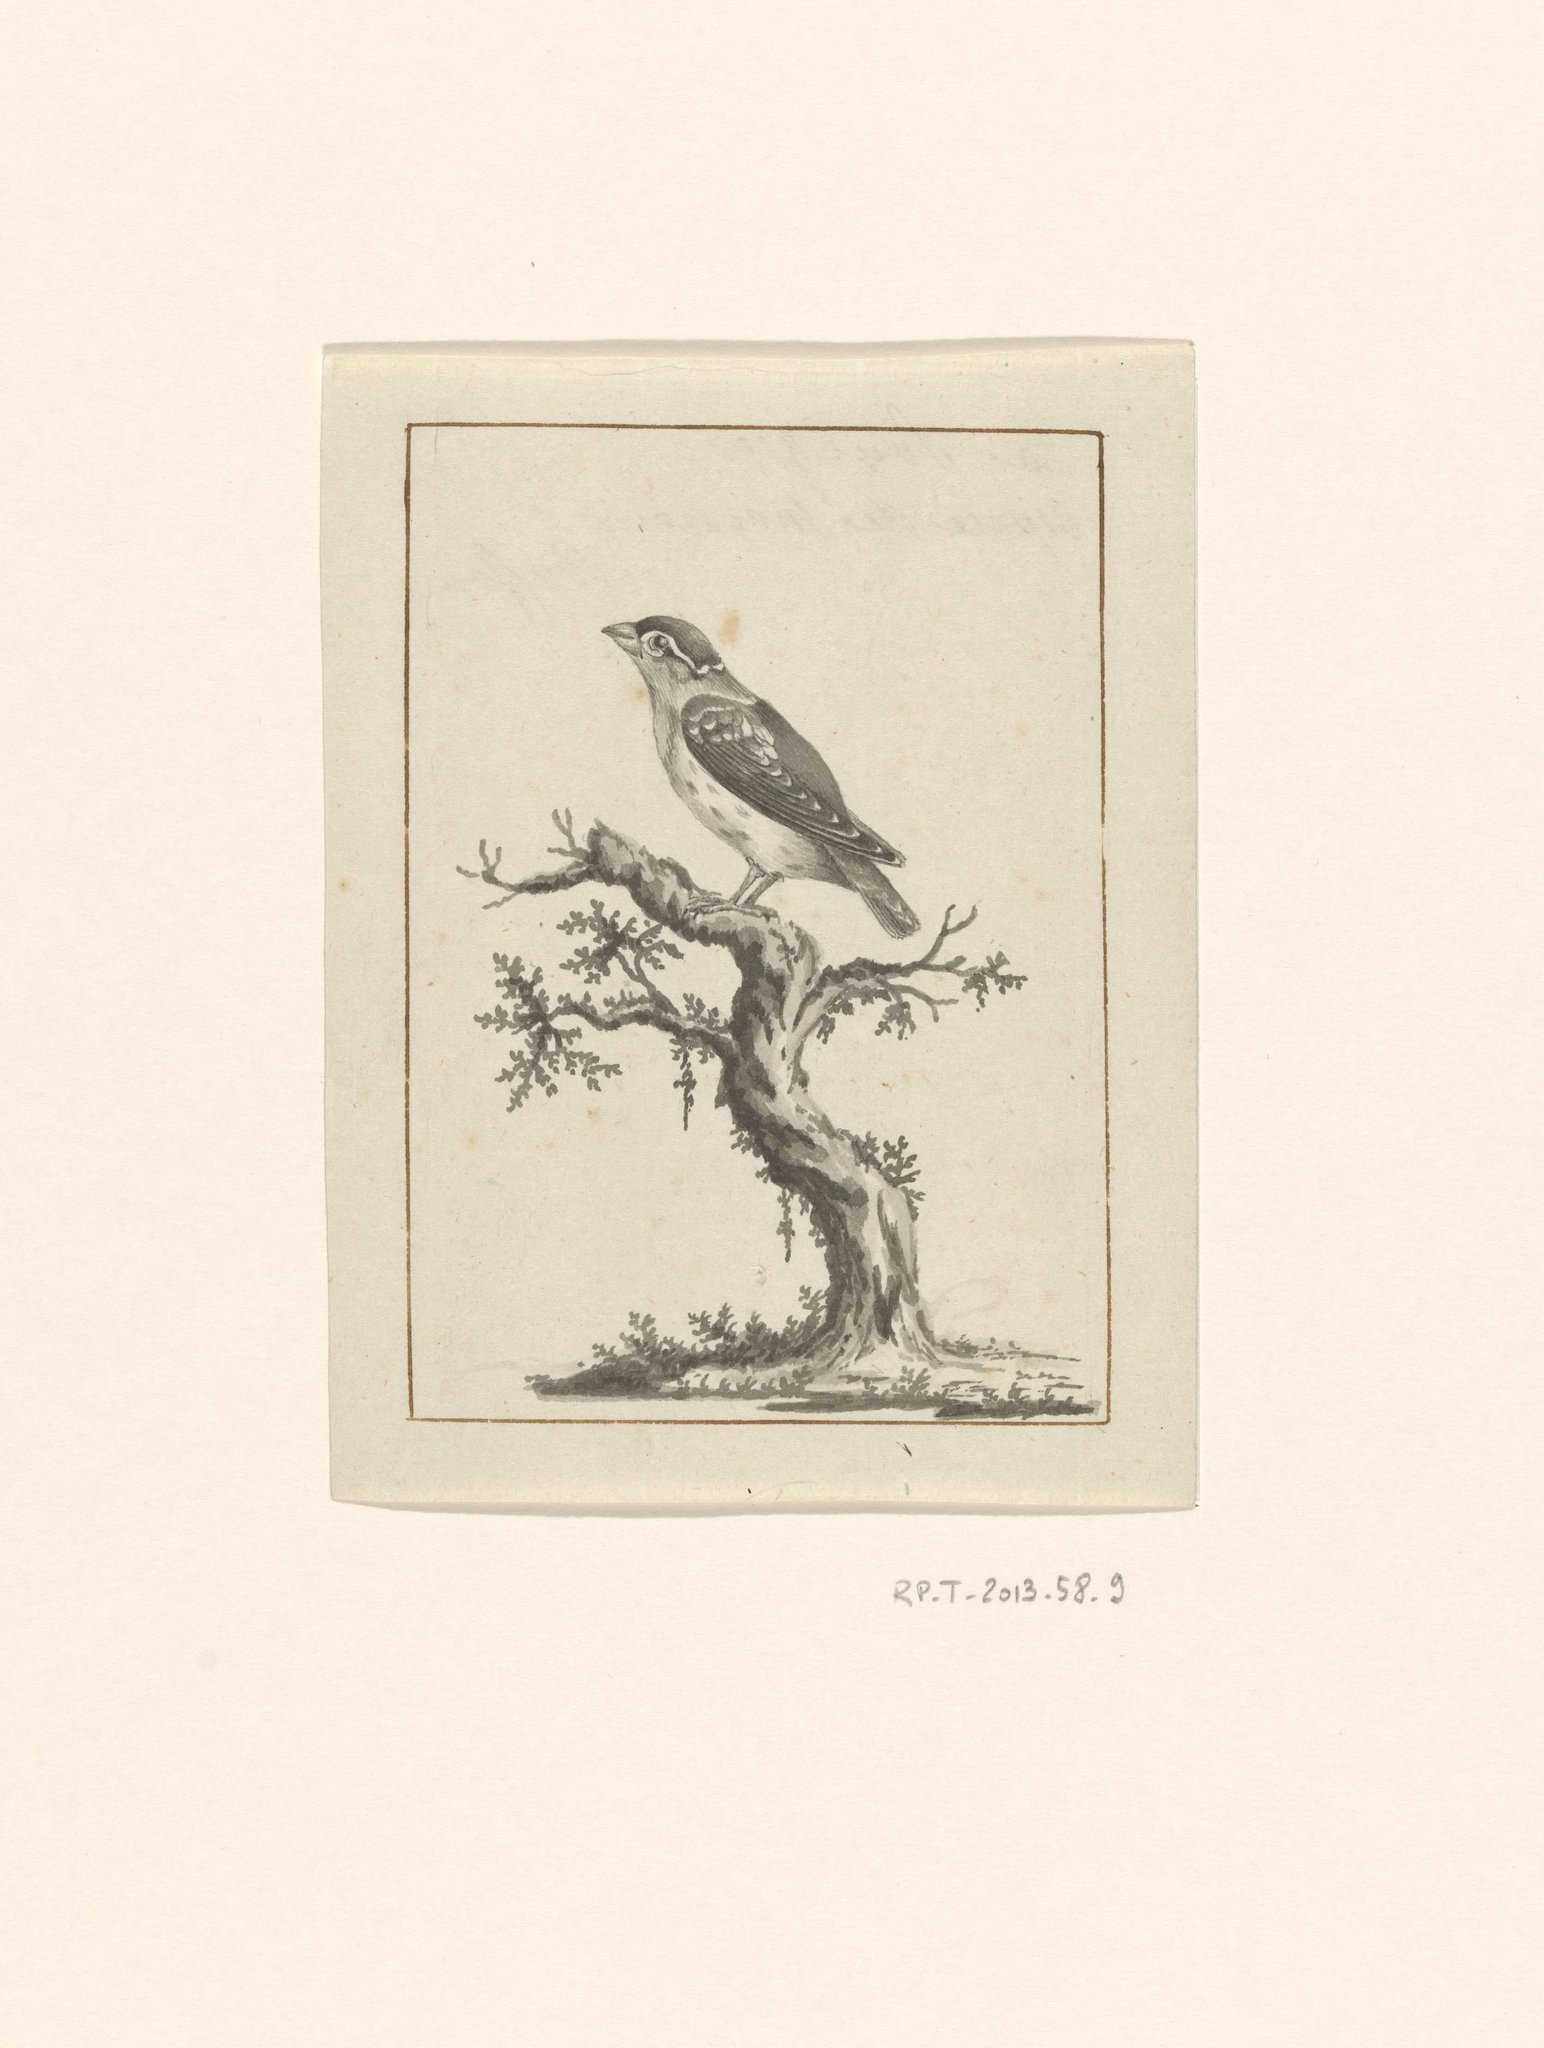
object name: drawing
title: Vogel in landschap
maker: krüger jr.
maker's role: draughtsman, painter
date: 1772-1809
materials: paper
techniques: brush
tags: birds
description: Voortekening voor een afbeelding in: Georges Buffon, Naturgeschichte der Vögel, Wenen: 1772-1809.